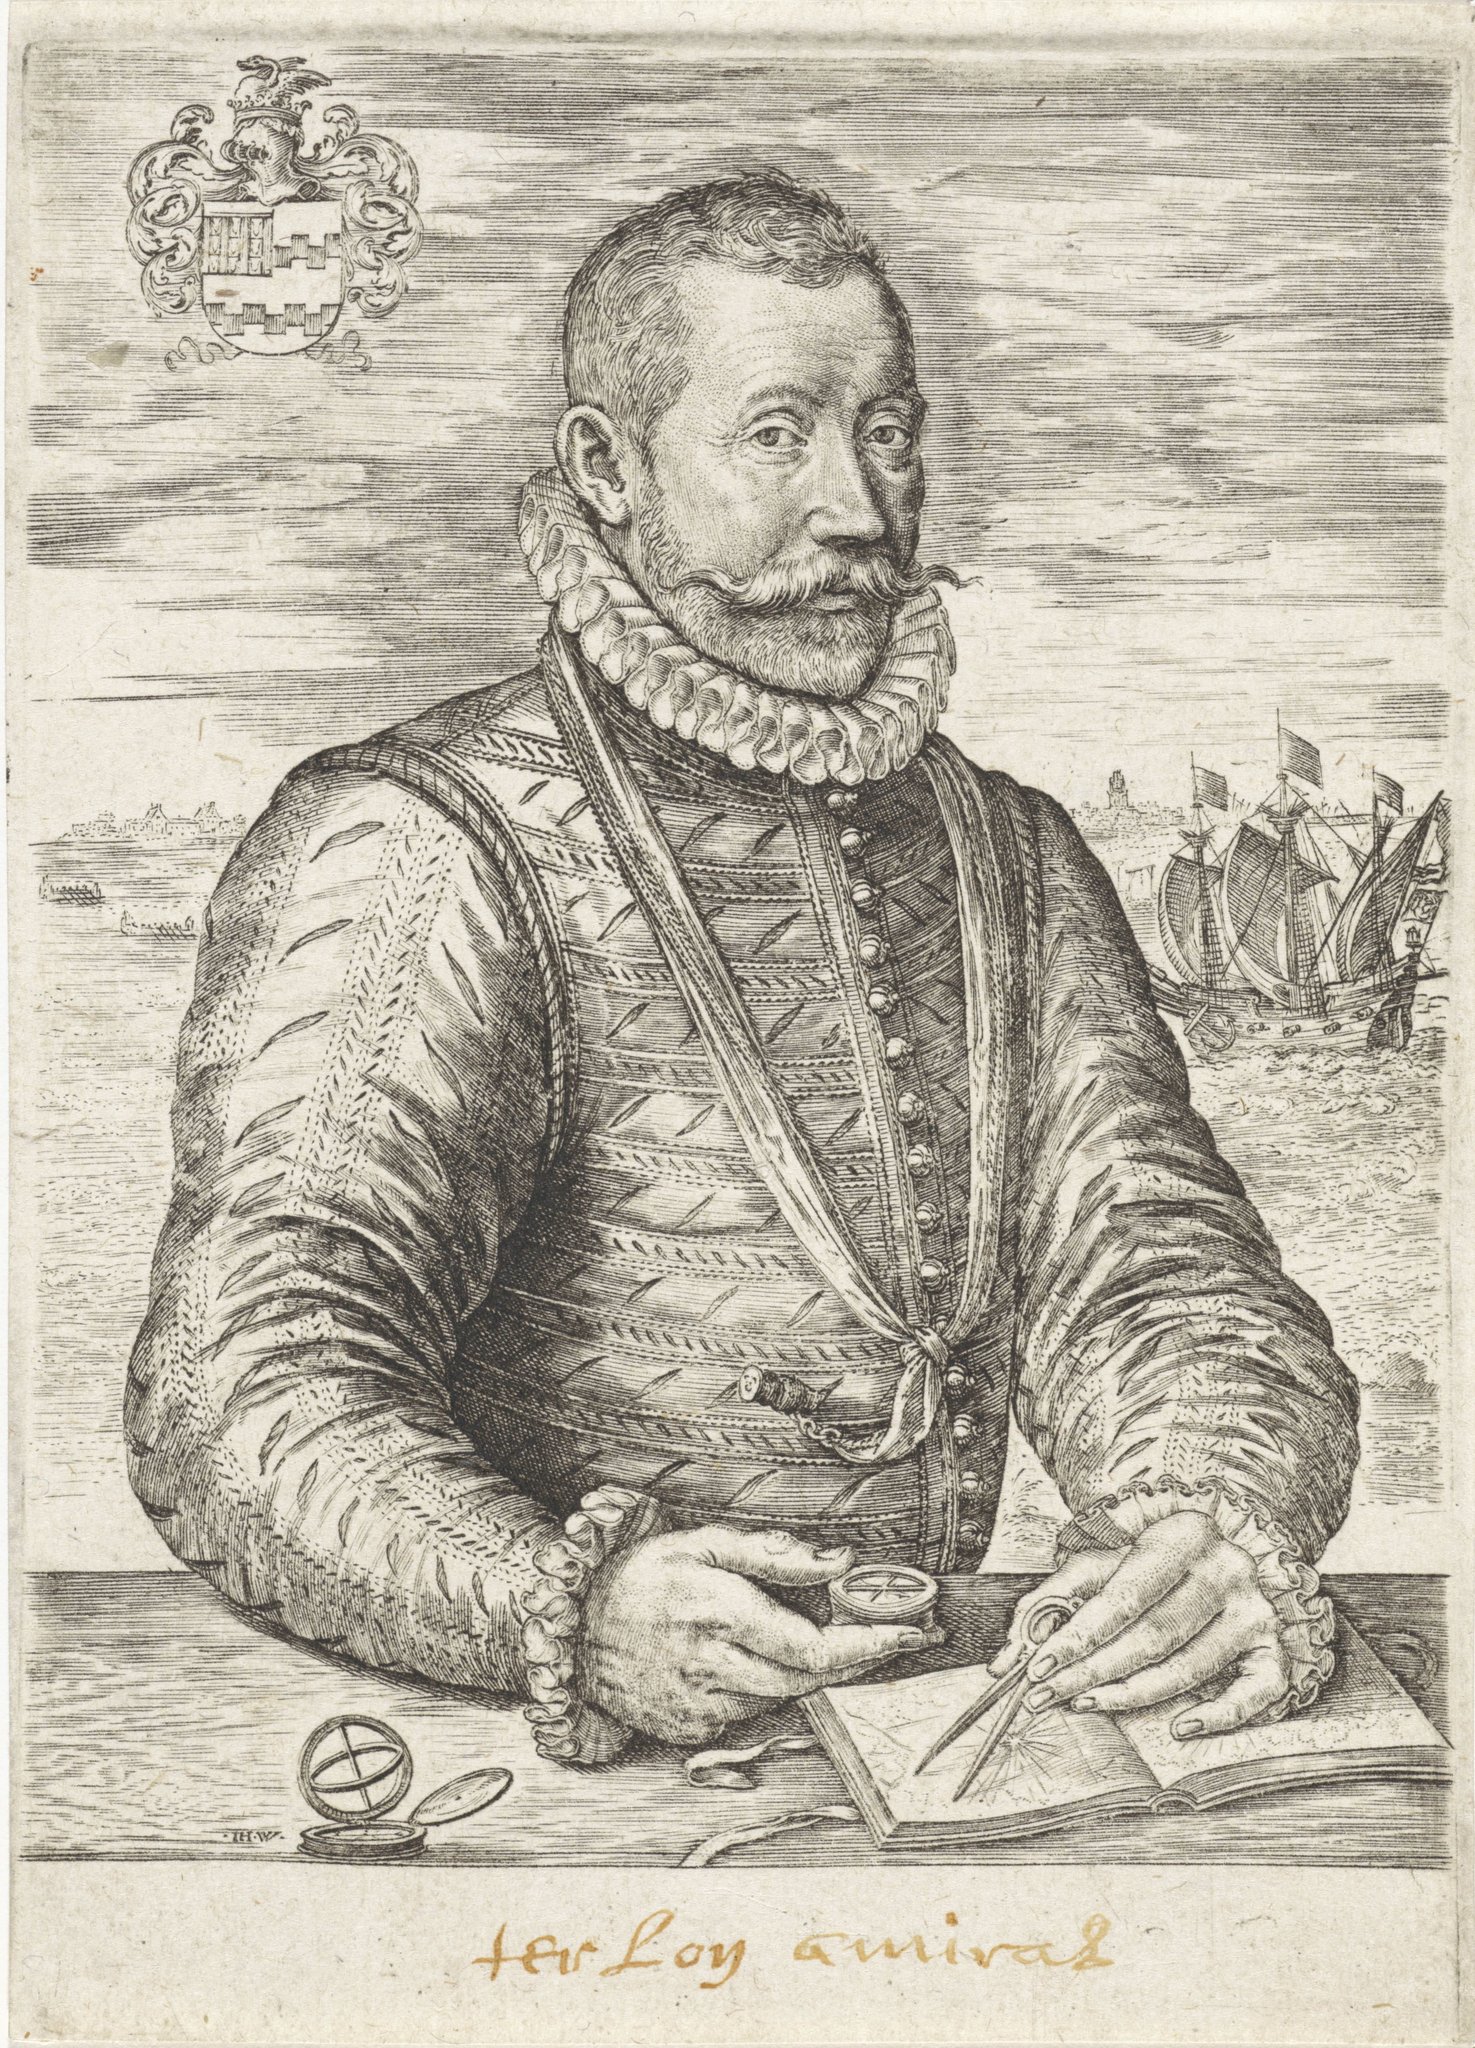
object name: print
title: Portret van de zeeofficier Willem Bloys van Treslong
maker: johannes wierix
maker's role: draughtsman, print maker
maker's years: 1549-1618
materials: paper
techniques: engraving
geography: antwerp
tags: brielle, marine charts, ships (in general), compass, armorial bearing, heraldry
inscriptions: collector's mark: Lugt 240, inscription: ‘Terloy amiral’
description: Hij houdt een kompas in de hand en tekent met een passer op een kaart. Op de achtergrond schepen op zee. Linksboven zijn wapenschild. Met een lege marge.